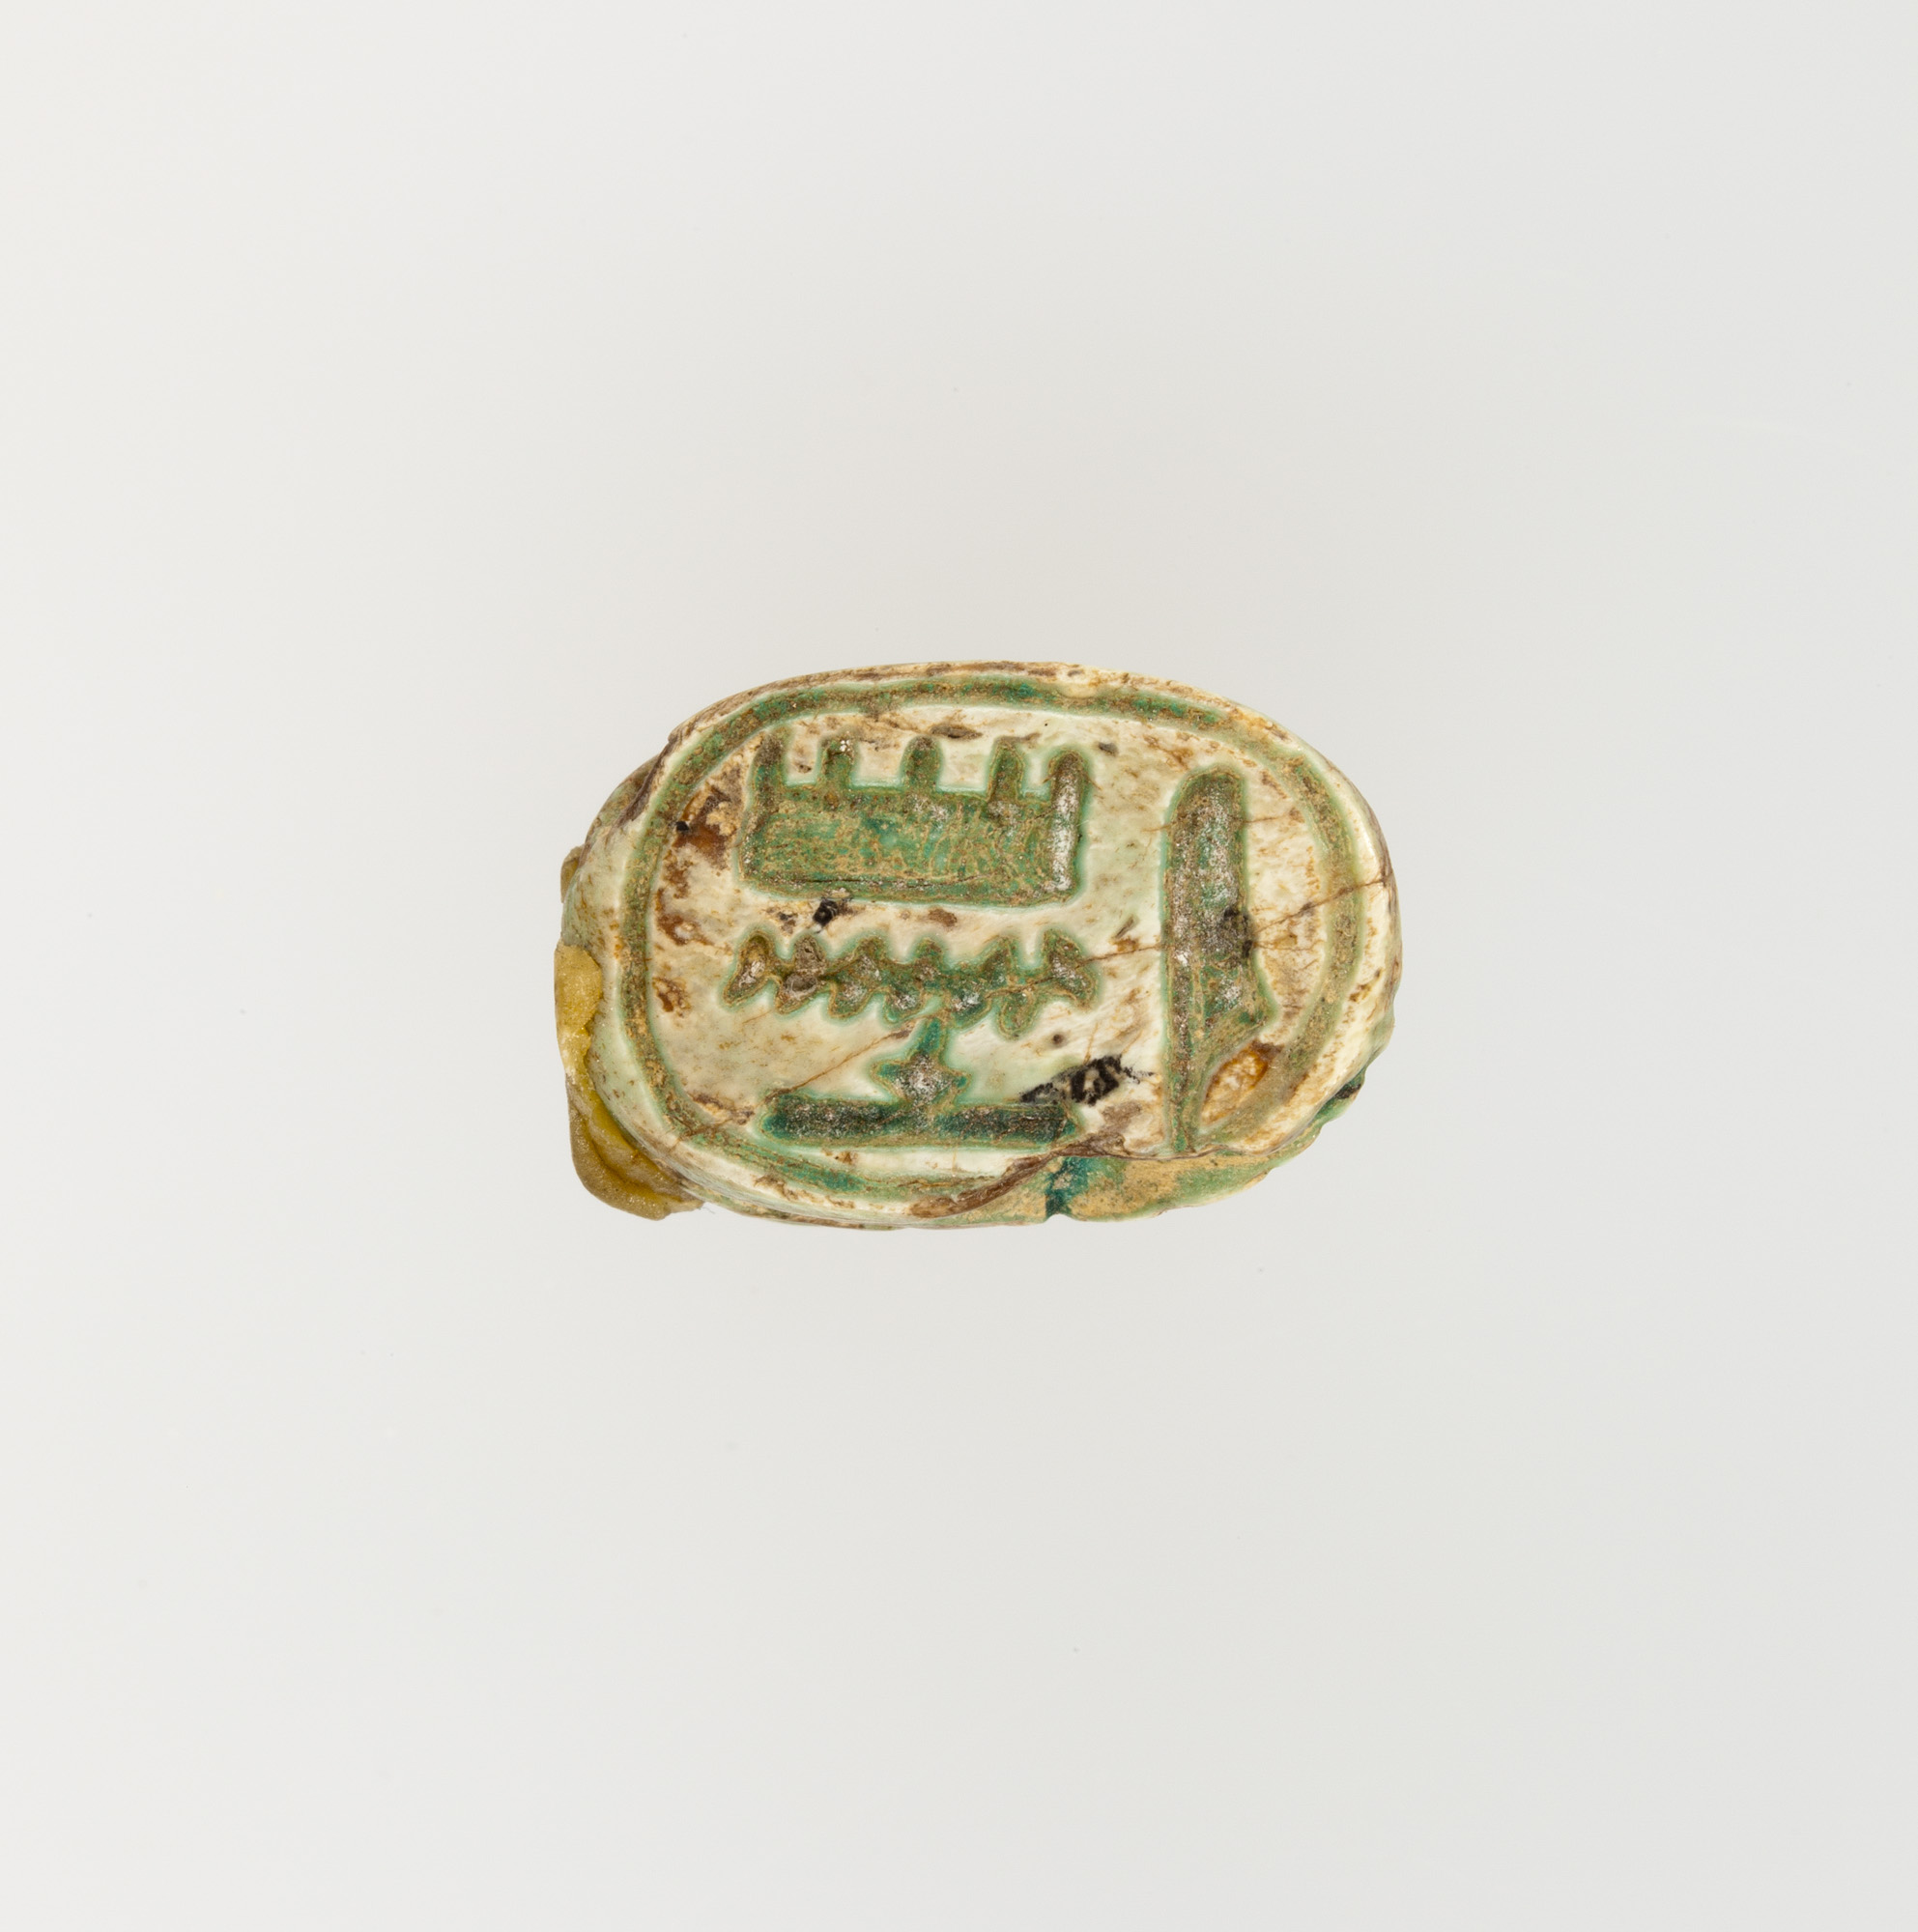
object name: scarab, amenhotep i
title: Scarab Inscribed with the Name Amtenhotep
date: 1525-1504 BCE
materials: stone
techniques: glazing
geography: egypt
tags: hieroglyphs,scarabs